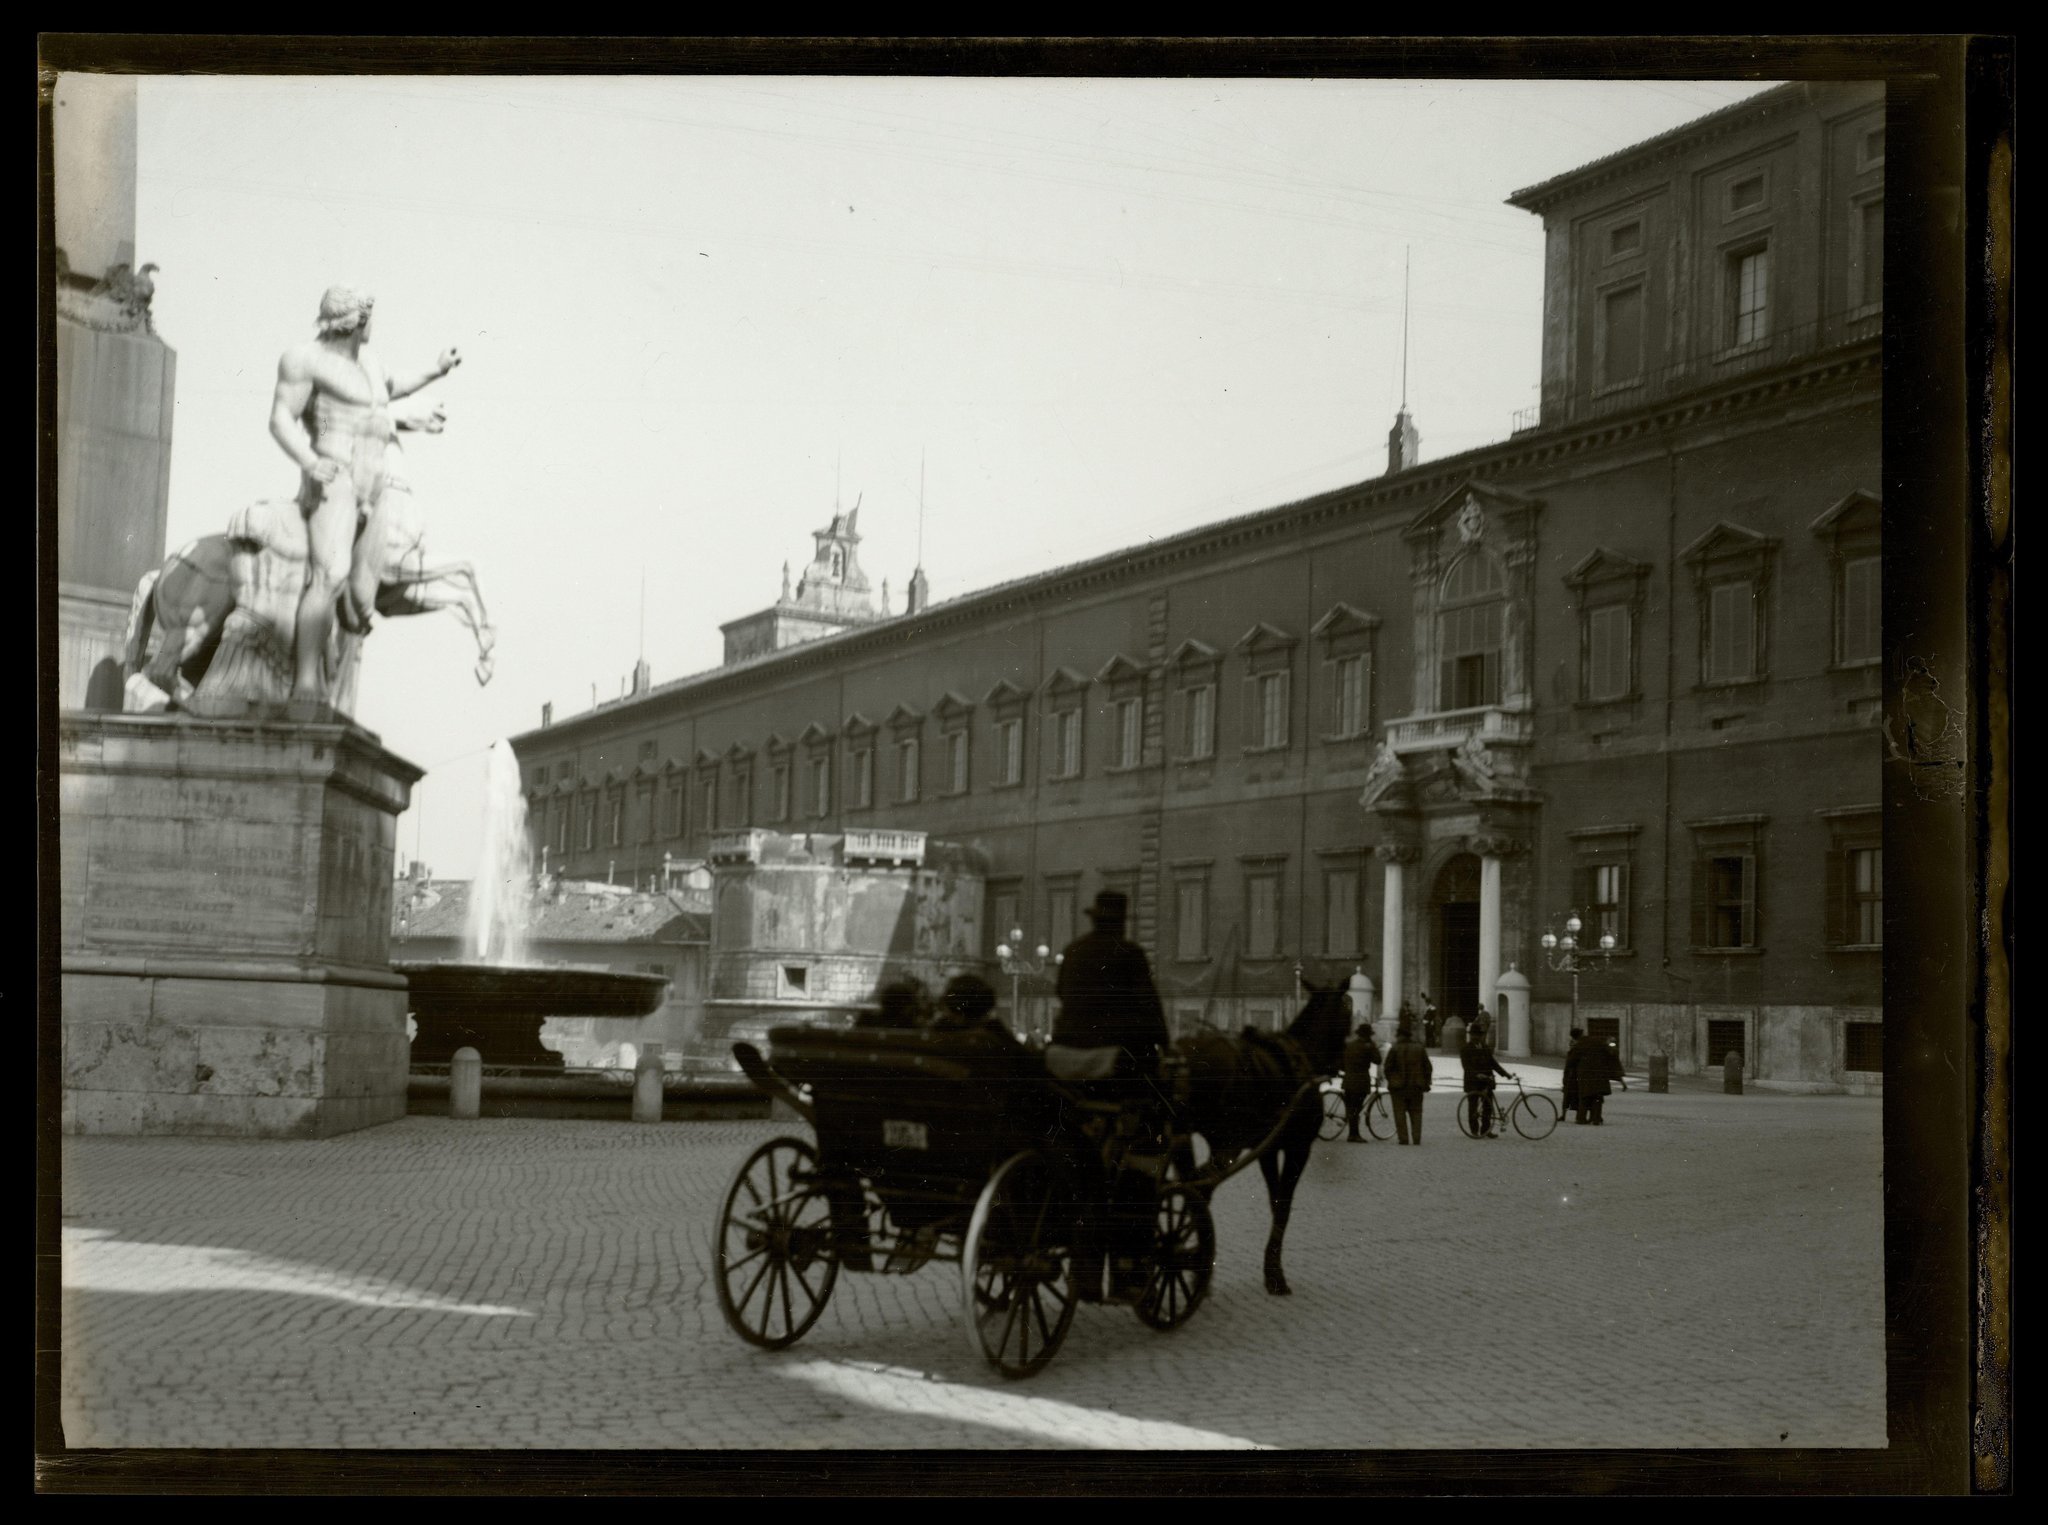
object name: photograph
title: Filmnegatief met opname van Rome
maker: Anonymous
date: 1907-1935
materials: film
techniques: gelatin silver negative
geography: rome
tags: rome